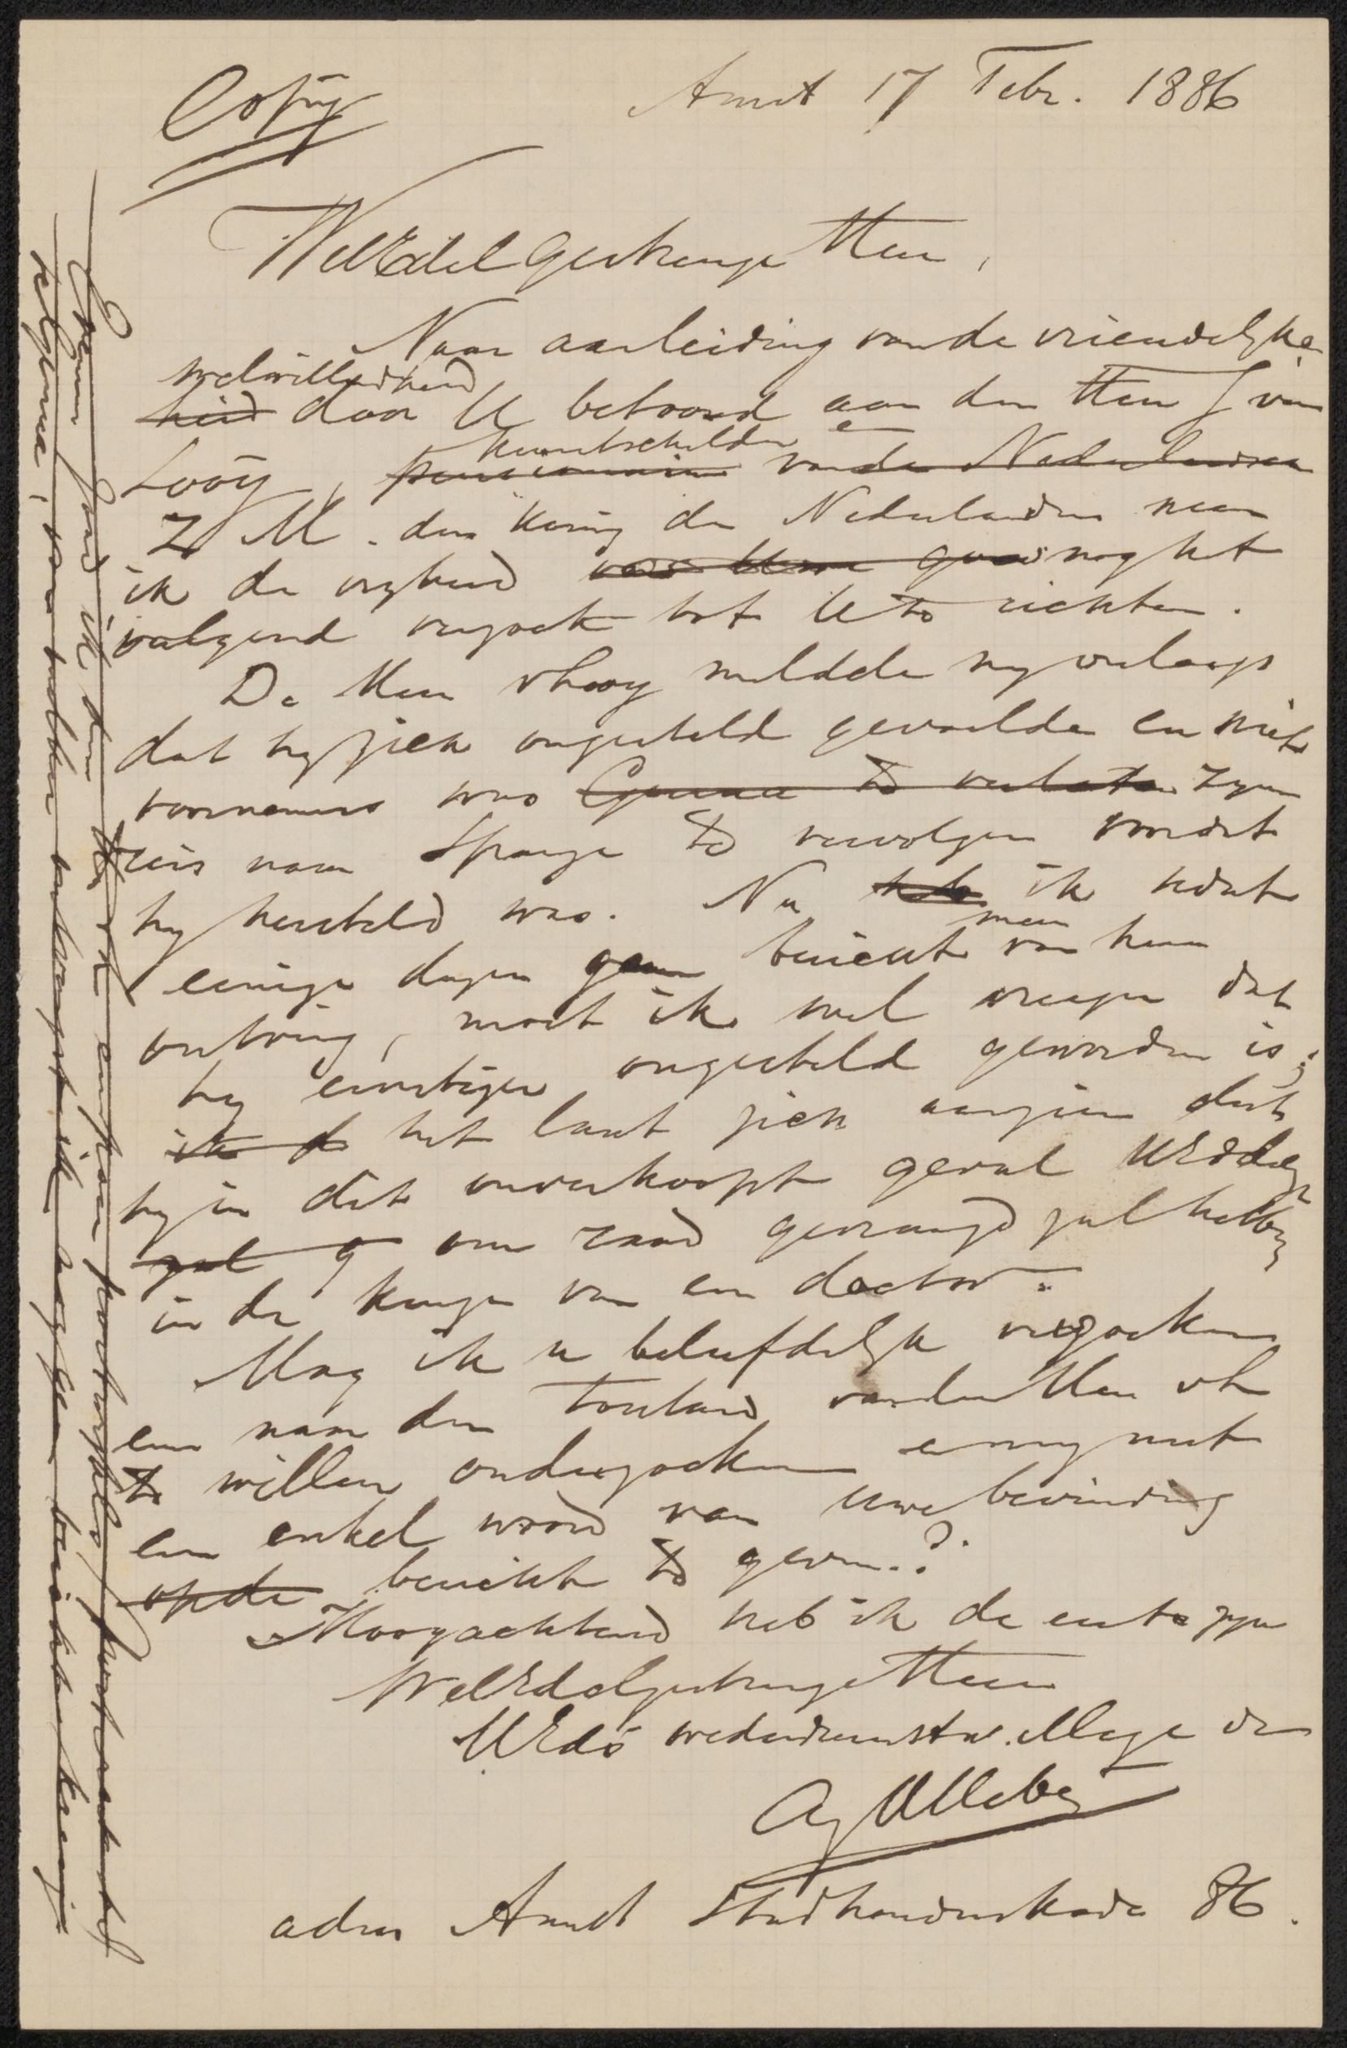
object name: letter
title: Brief aan anoniem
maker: august allebé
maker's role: draughtsman, print maker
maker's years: 1838-1927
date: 1886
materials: ink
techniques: pen, writing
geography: amsterdam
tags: painter, print maker, draughtsman, jac van looij, travelling; tourism, diseases, spain